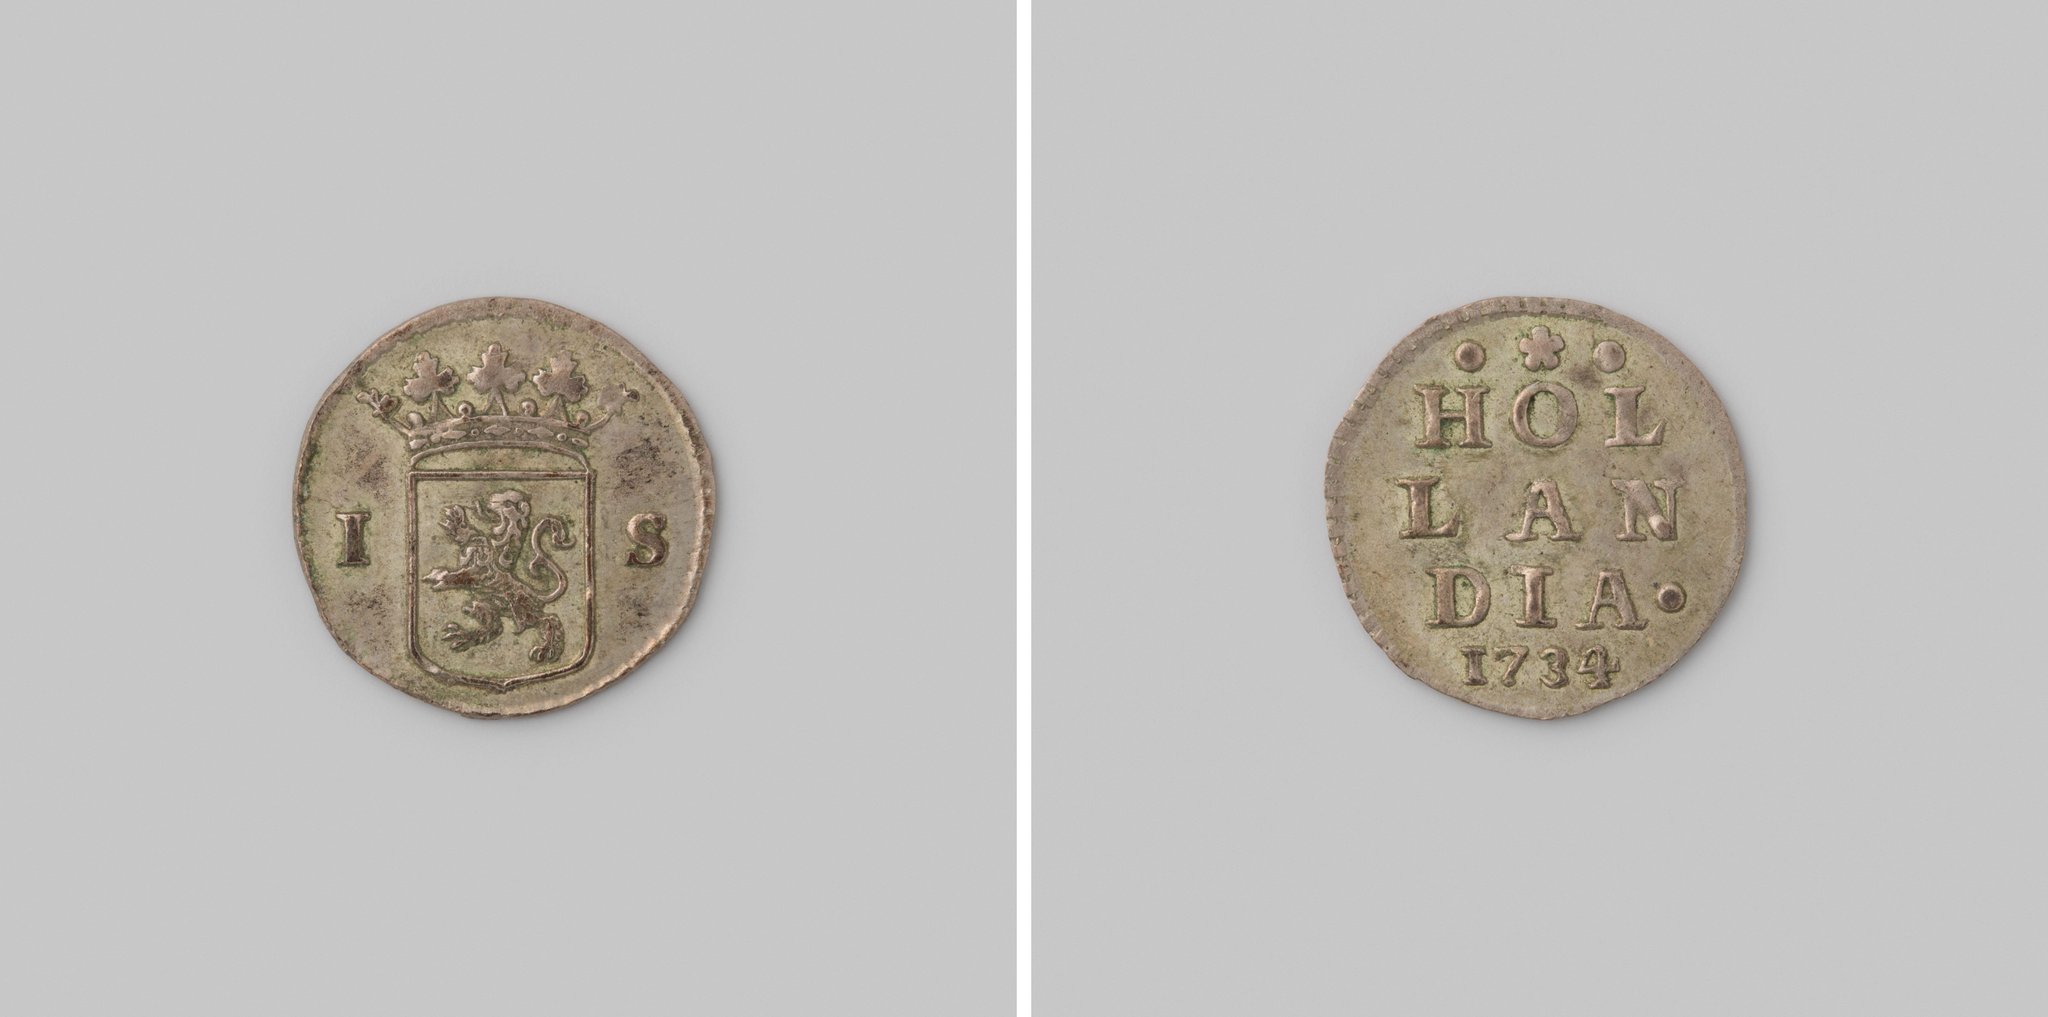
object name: coin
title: Holland, wapenstuiver, 1734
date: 1734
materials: silver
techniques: striking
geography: dordrecht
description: Zilveren munt. Voorzijde: tussen waarde-aanduiding gekroond wapenschild van Holland. Keerzijde: opschrift: provincienaam in drie regels, daaronder jaartal.